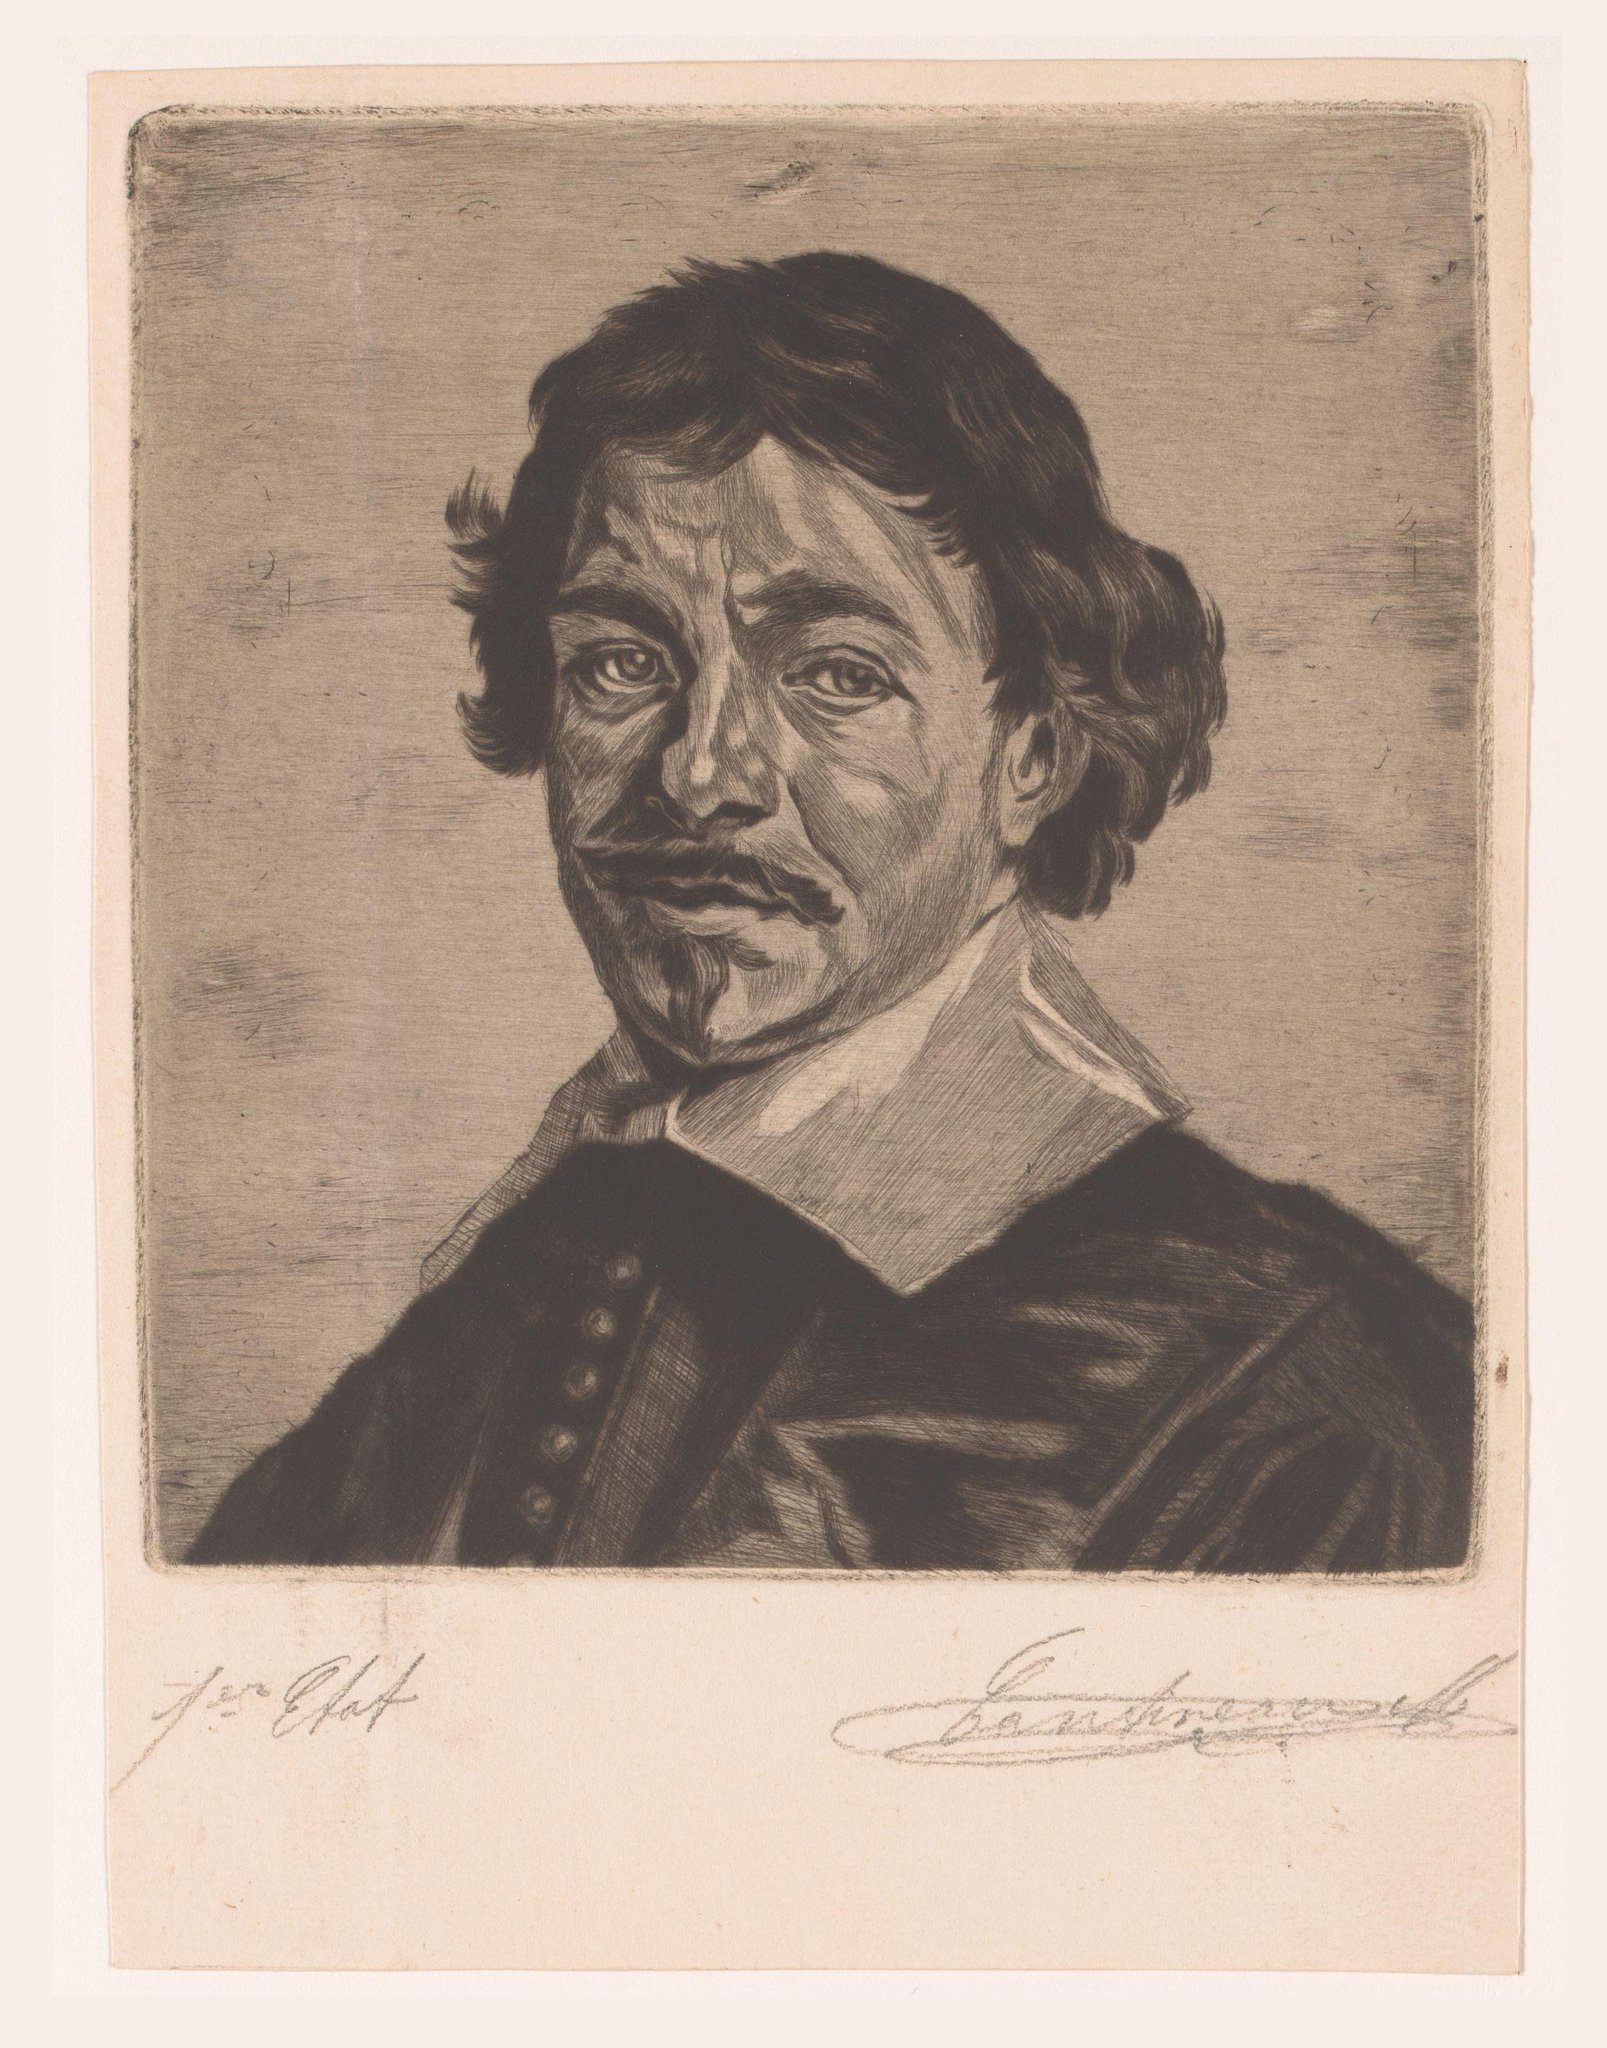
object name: print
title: Portret van Frans Hals, naar een zelfportret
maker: mary hector rupert cantineau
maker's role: draughtsman, print maker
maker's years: 1875-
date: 1885-1909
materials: paper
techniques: drypoint, etching, intaglio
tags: antwerp, haarlem, draughtsman, frans hals, portrait, self-portrait of artist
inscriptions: annotation: ‘1er état’, collector's mark: Lugt 2228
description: Sterfdatum prentmaker onbekend. Derhalve is voor bepaling van de rechten van dit object de verwervingsdatum aangehouden.